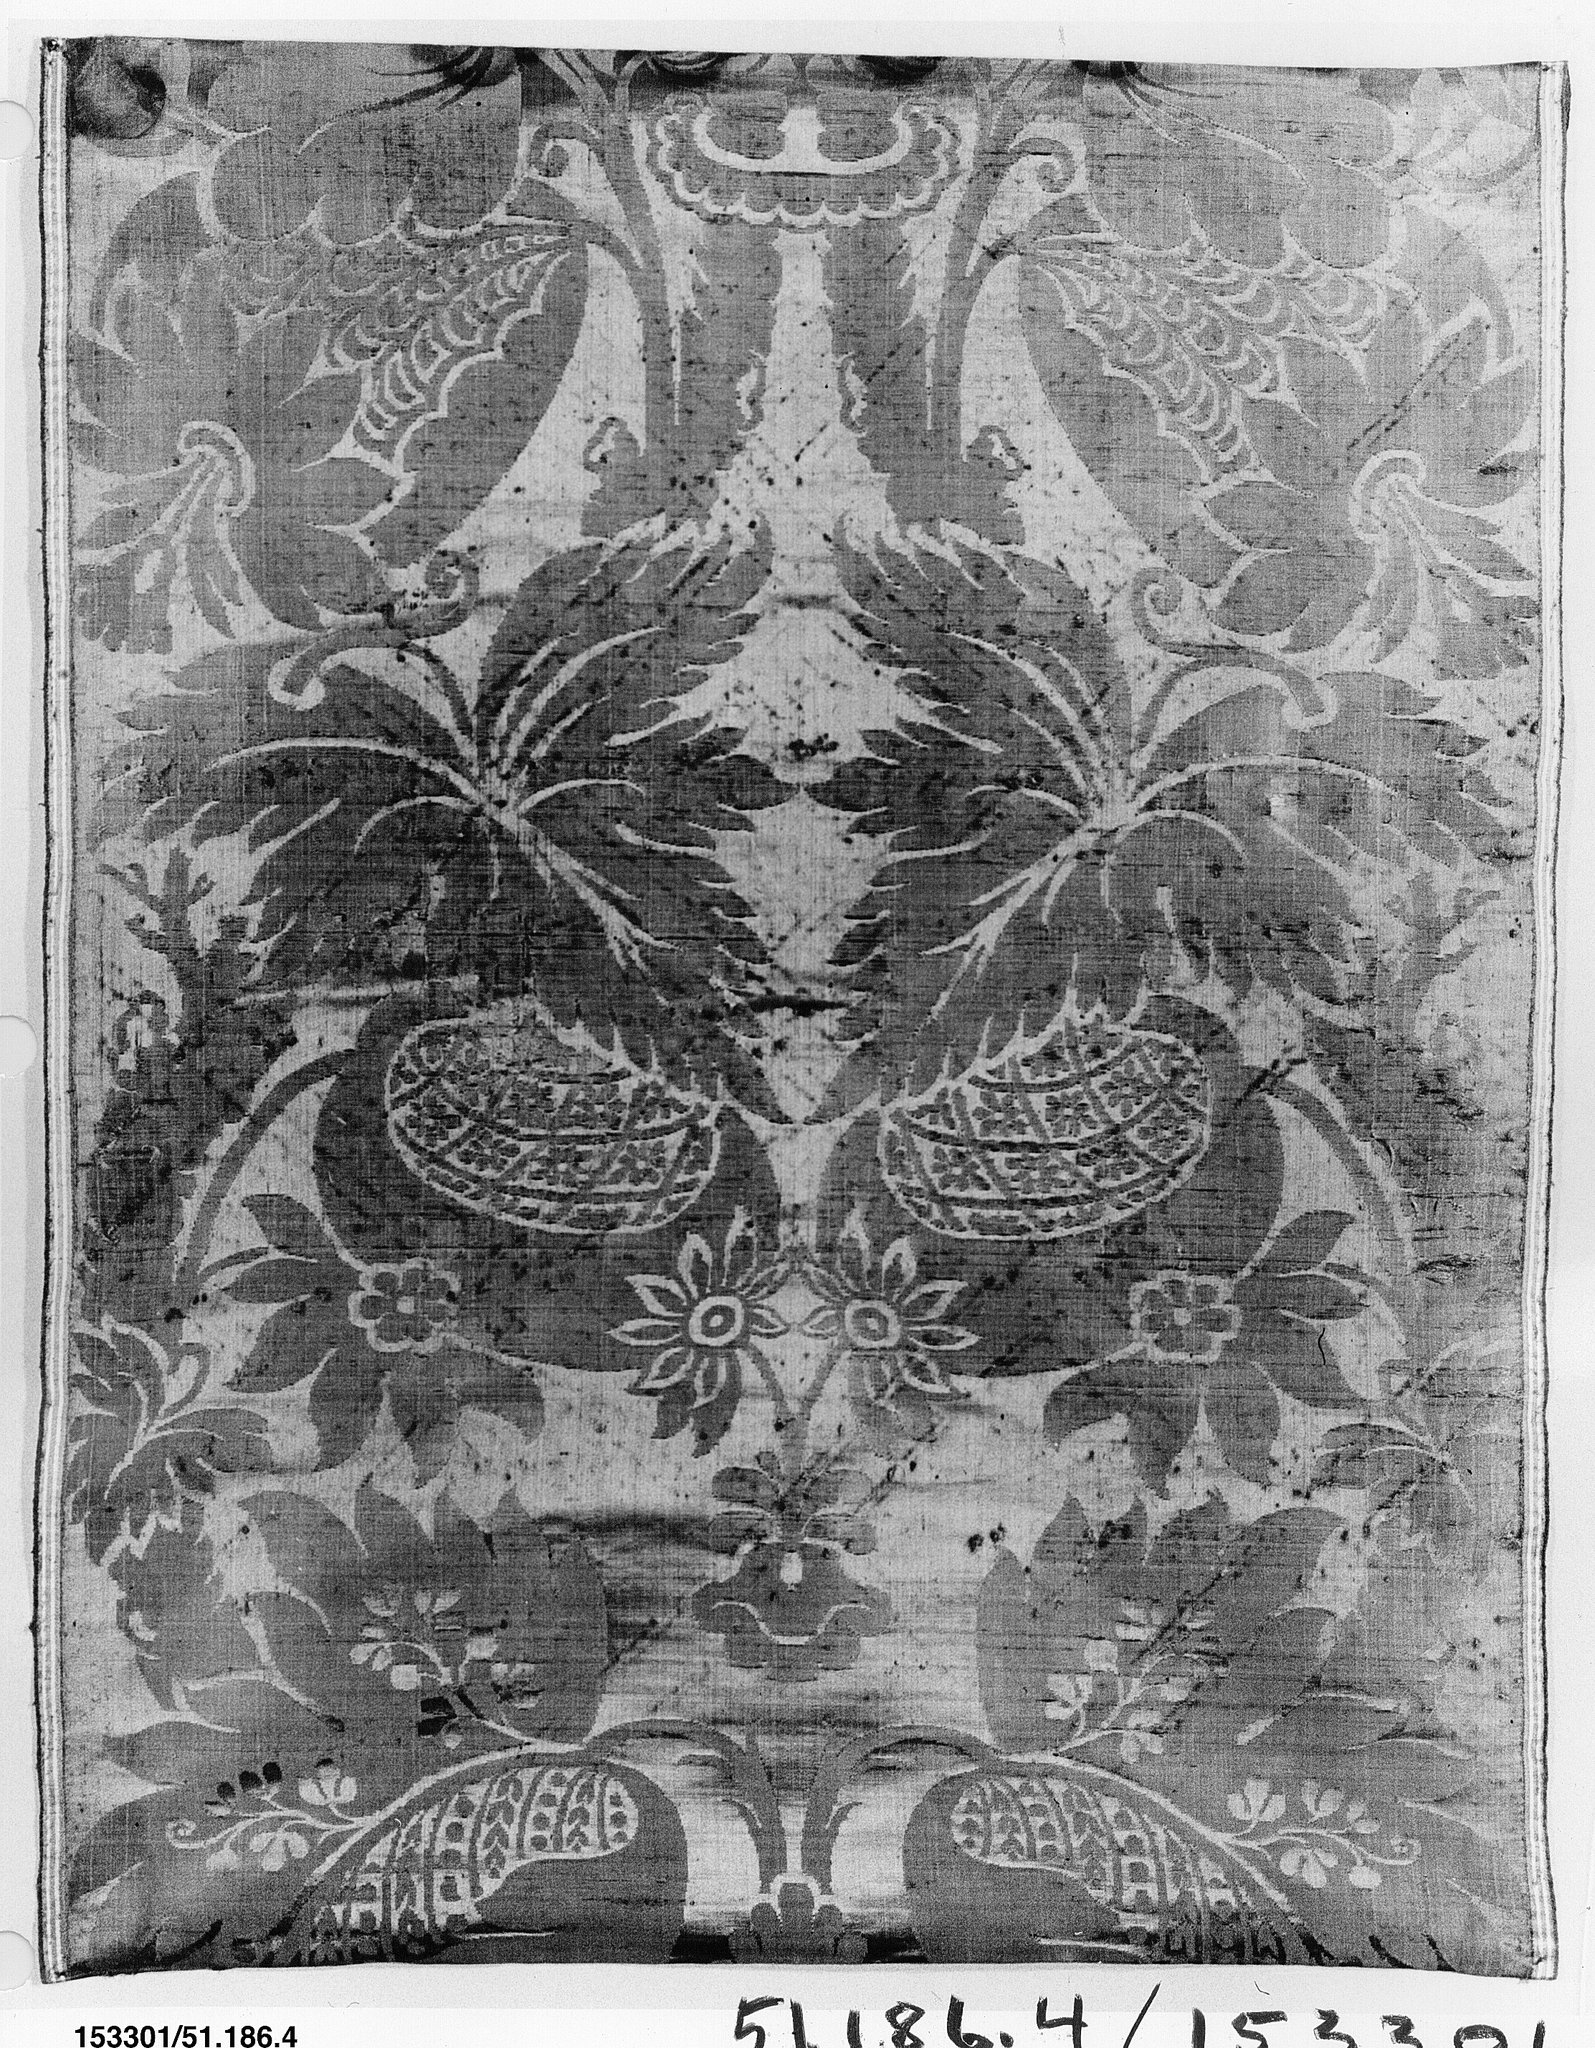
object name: piece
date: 1730-1740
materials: silk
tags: flowers,leaves